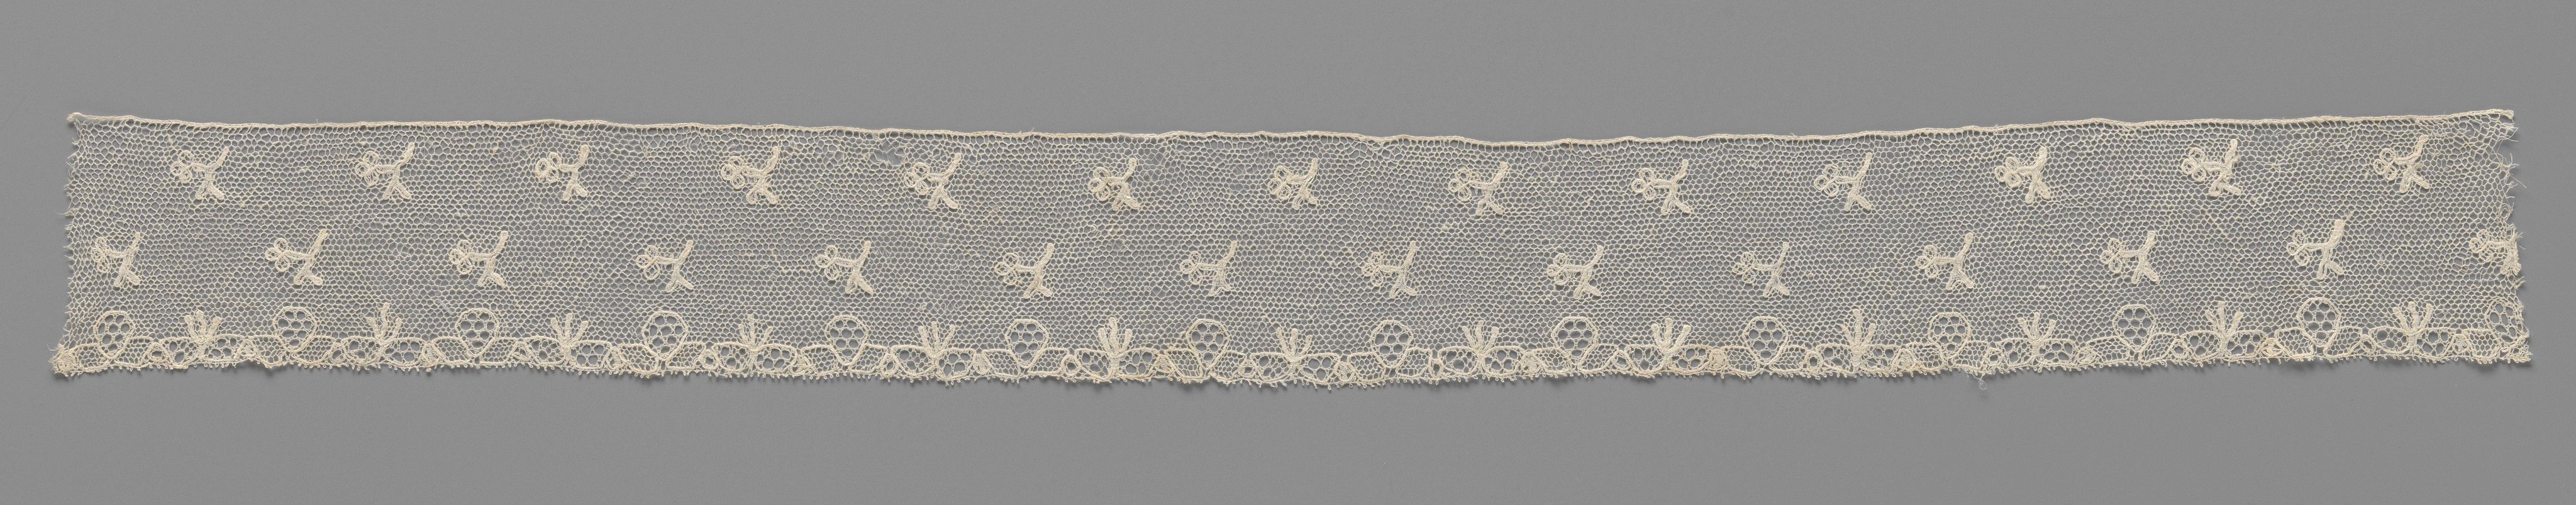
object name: strip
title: Strook kloskant met sierrand van gedrongen gestileerde bloemen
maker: Anonymous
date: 1790-1799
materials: linen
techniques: lace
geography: lille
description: Strook naturelkleurige kloskant: Rijselse kant. Onder een strooipatroon van twee rijen eenzijdig gerichte bloemtakjes met een bloempje met drie ronde bloemblaadjes, loopt langs de onderzijde een sierrand. Deze bestaat uit een aaneenschakeling van recht opstaande gedrongen bloemen in twee varianten. Het zijn afwisselend een druppelvormige gestileerde bloem tussen twee bladeren en een gestileerde bloem in de vorm van een vork met drie tanden tussen twee bladeren. De motieven zijn gemaakt met dikkere en glimmende contourdraden waarbinnen al dan niet een siergrondje, een rozengrond, is toegepast. De steeltjes van de bloemen in het strooipatroon en de vorkbloemen zijn gemaakt in spaarzaam toegepaste linnenslag. Rond alle motieven lopen dikkere en glimmende contourdraden. De motieven zijn met elkaar verbonden door een traliegrond, een tulegrond. Boven- en onderzijde van de strook zijn recht afgewerkt, waarbij de onderzijde is voorzien van picots.